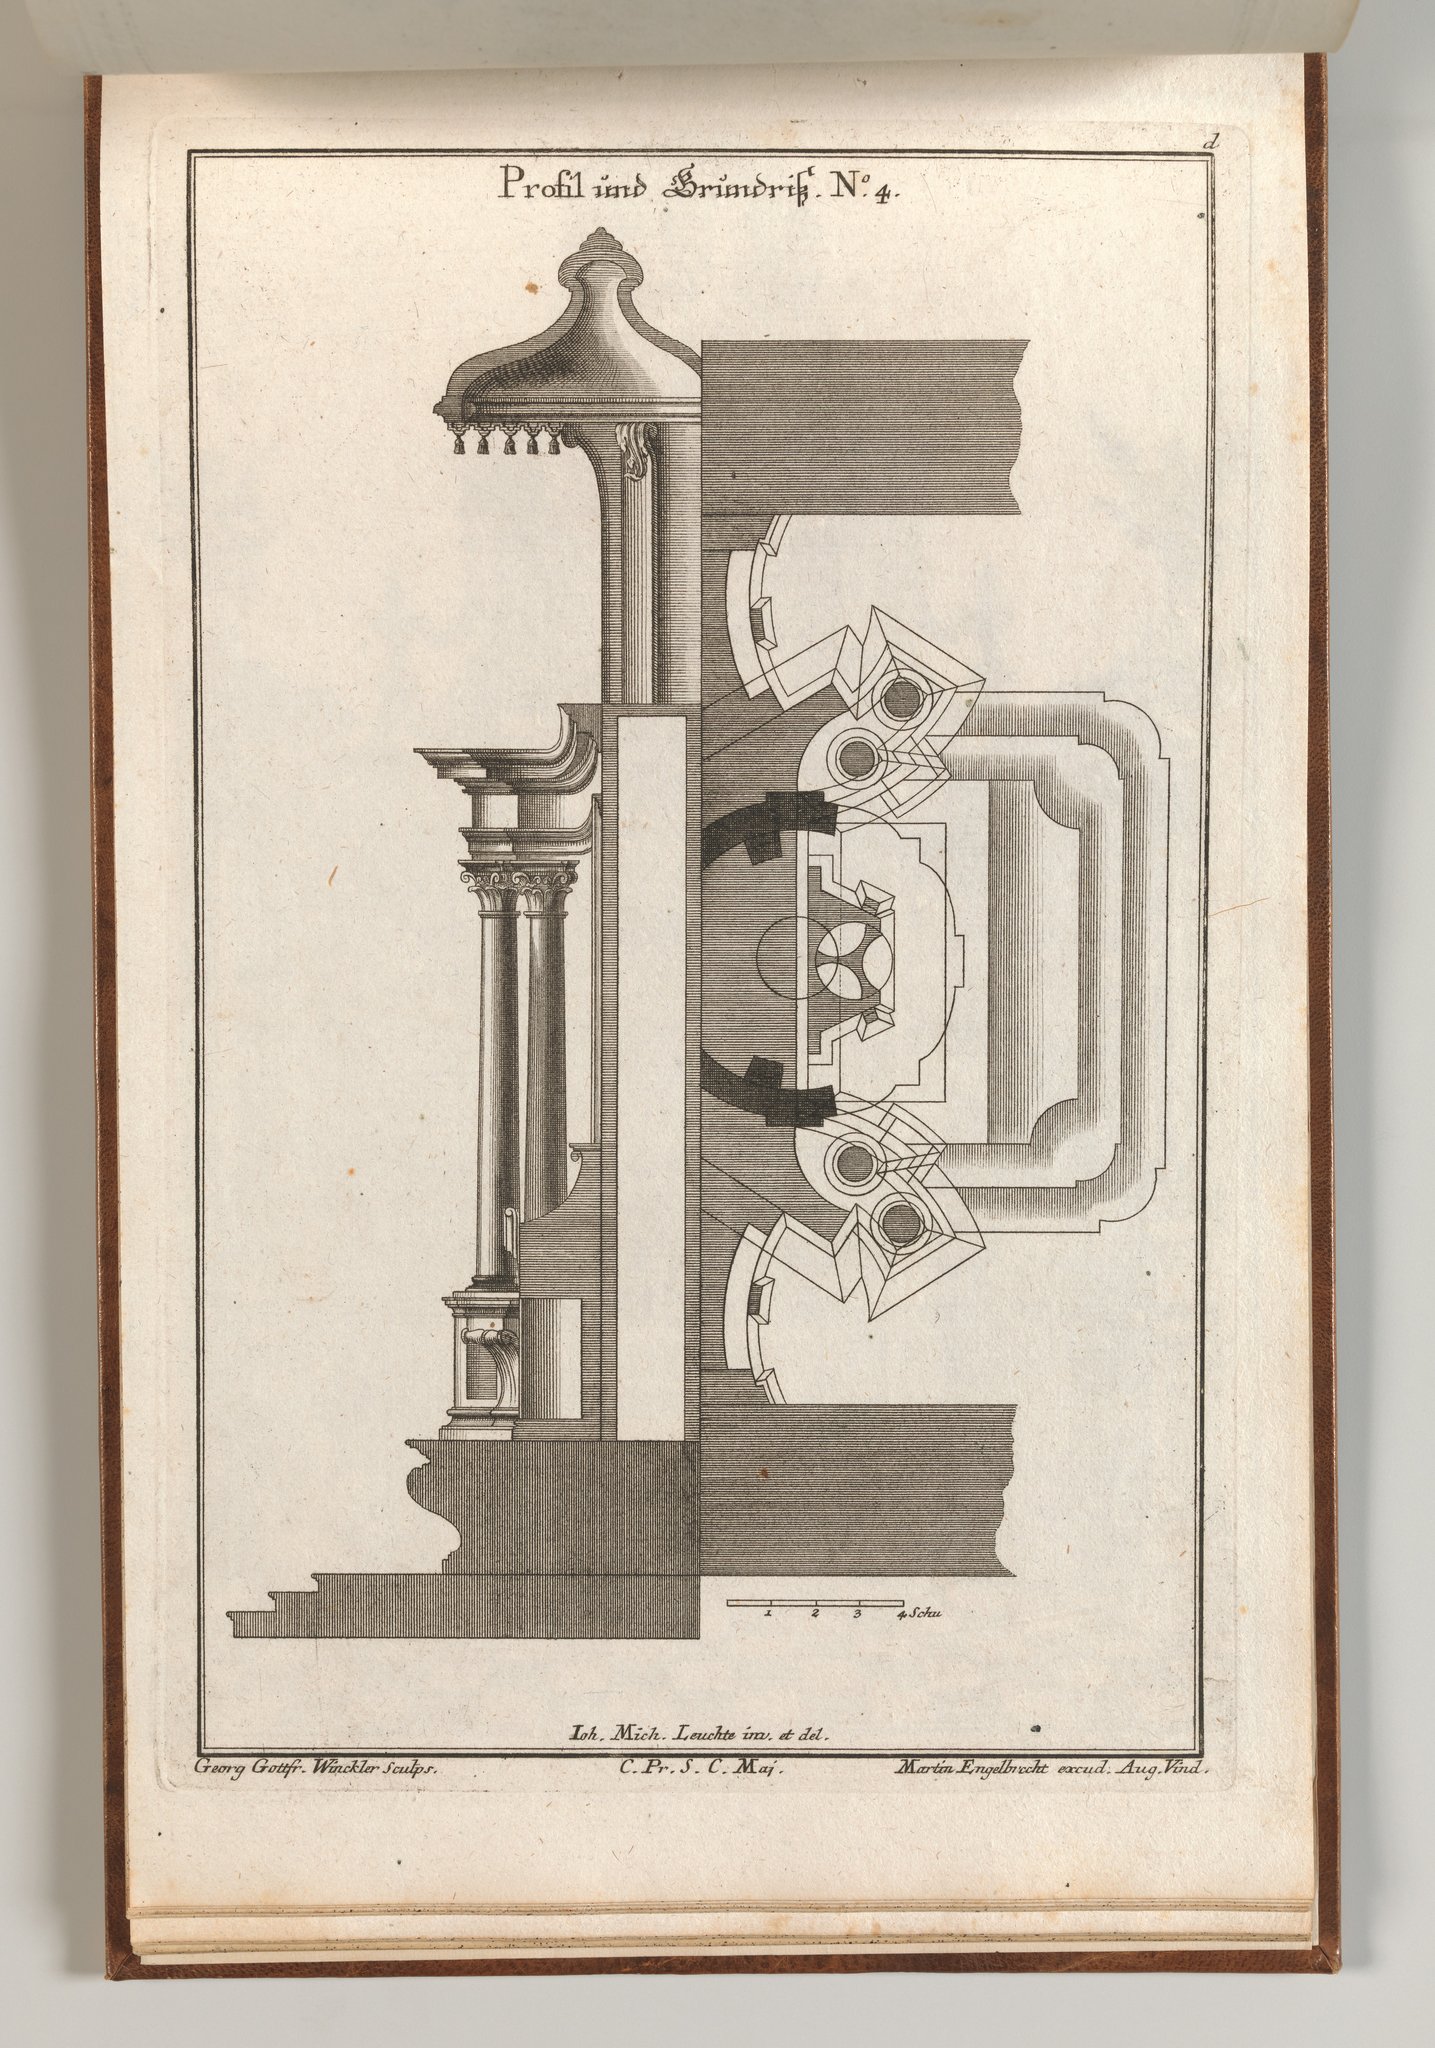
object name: album print ornament architecture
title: Floorplan and Side View of an Altar, Plate d (2) from 'Unterschiedliche Neu Inventierte Altäre mit darzu gehörigen Profillen u. Grundrißen.'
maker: georg gottfried winckler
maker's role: engraver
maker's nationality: german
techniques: etching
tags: architecture,altars